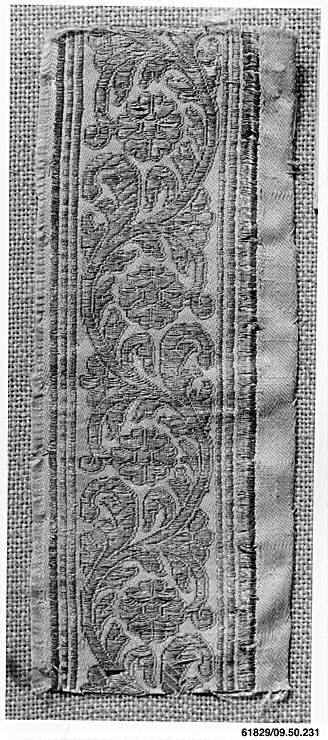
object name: textile fragment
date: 1801-1900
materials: metal thread, silk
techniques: brocade, weave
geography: india